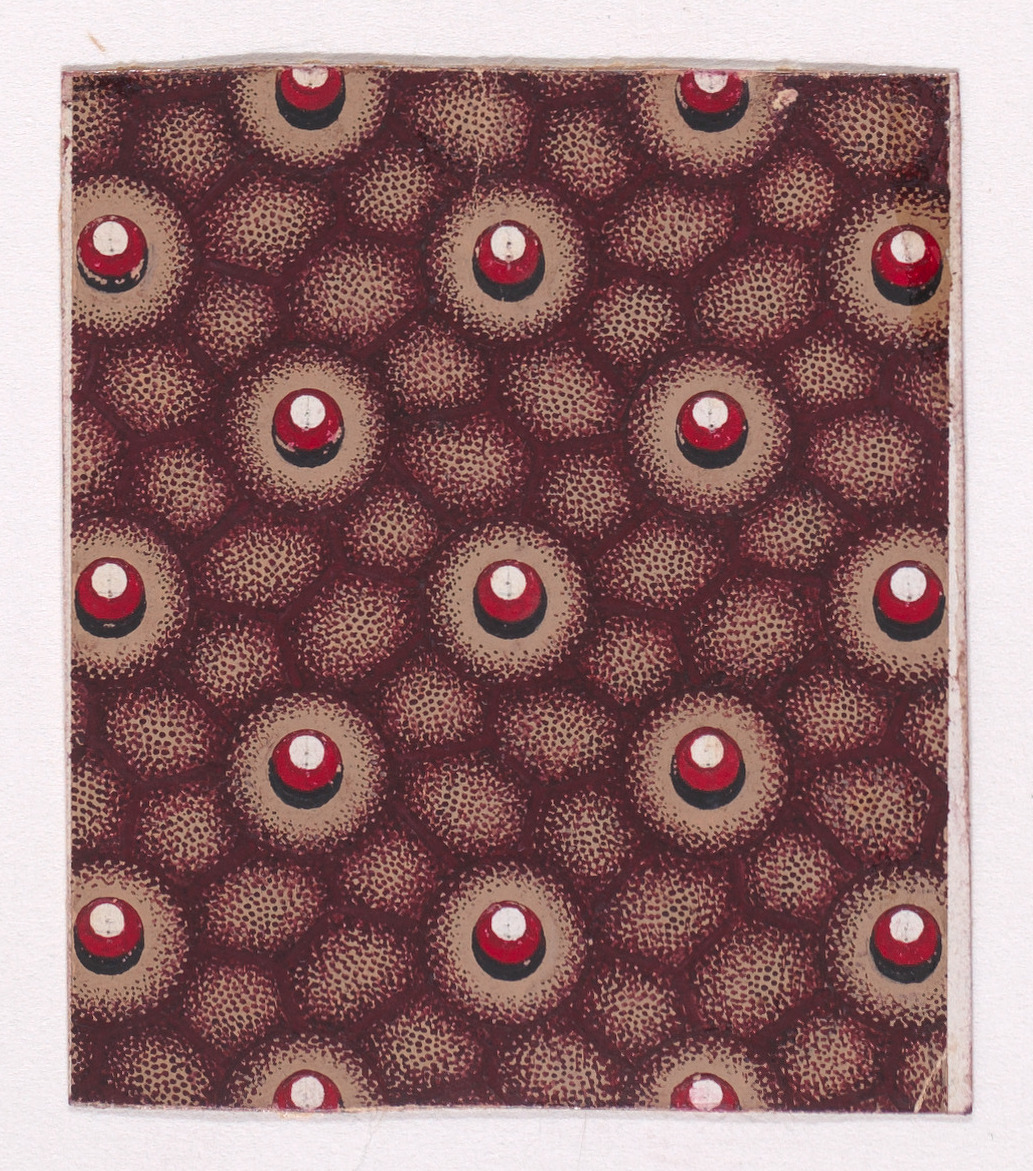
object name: drawing ornament architecture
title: Textile Design with Alternating Pearls over an Abstrack Honeycomb Pattern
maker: anonymous, alsatian, 19th century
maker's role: artist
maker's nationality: alsatian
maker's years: 1800-1900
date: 1840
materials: gouache